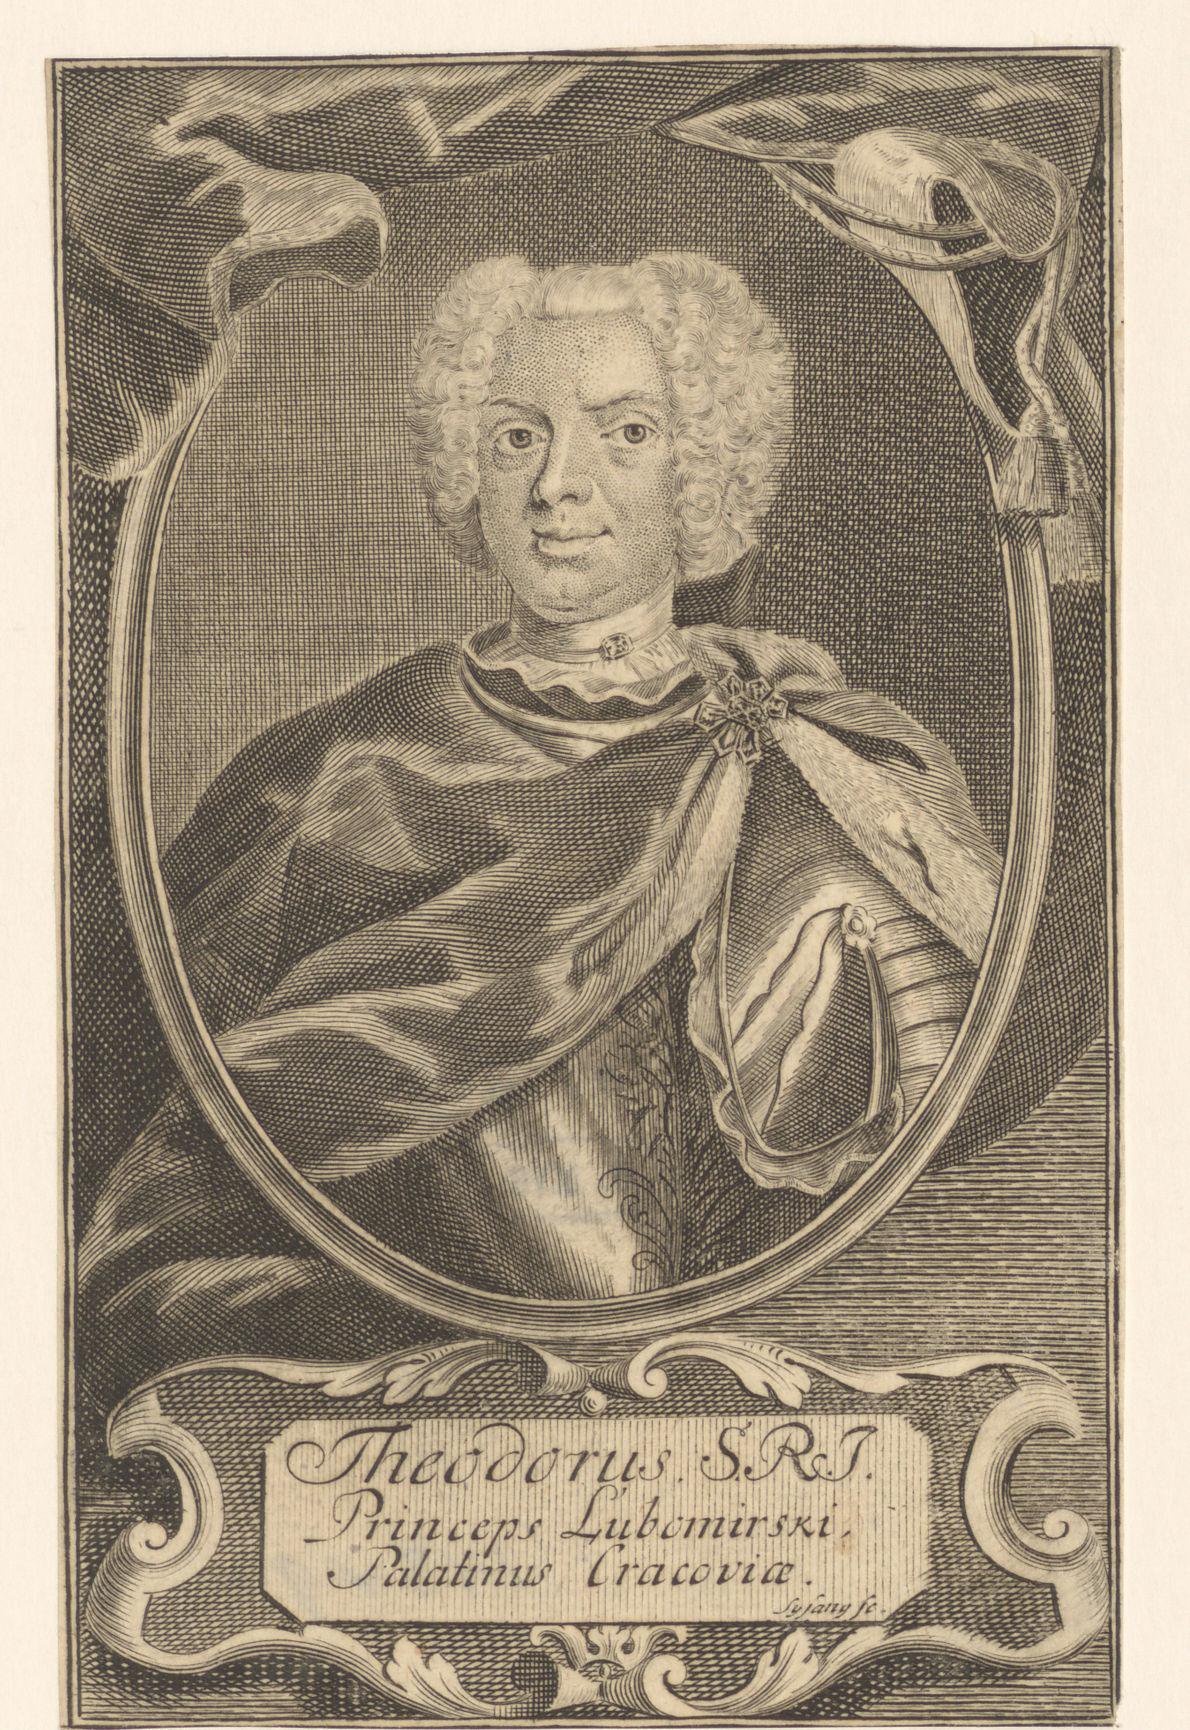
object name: print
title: Portret van Teodor, Fürst Lubomirski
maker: johann christoph sysang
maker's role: print maker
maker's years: 1703-1757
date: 1735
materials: paper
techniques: engraving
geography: leipzig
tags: armour, historical persons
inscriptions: collector's mark: Lugt 2228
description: Prent gebruikt voor de publicatie: Europäischer Staats-Secretarius. Leipzig: Moritz Georg II Weidmann, 1735, dl. 22.